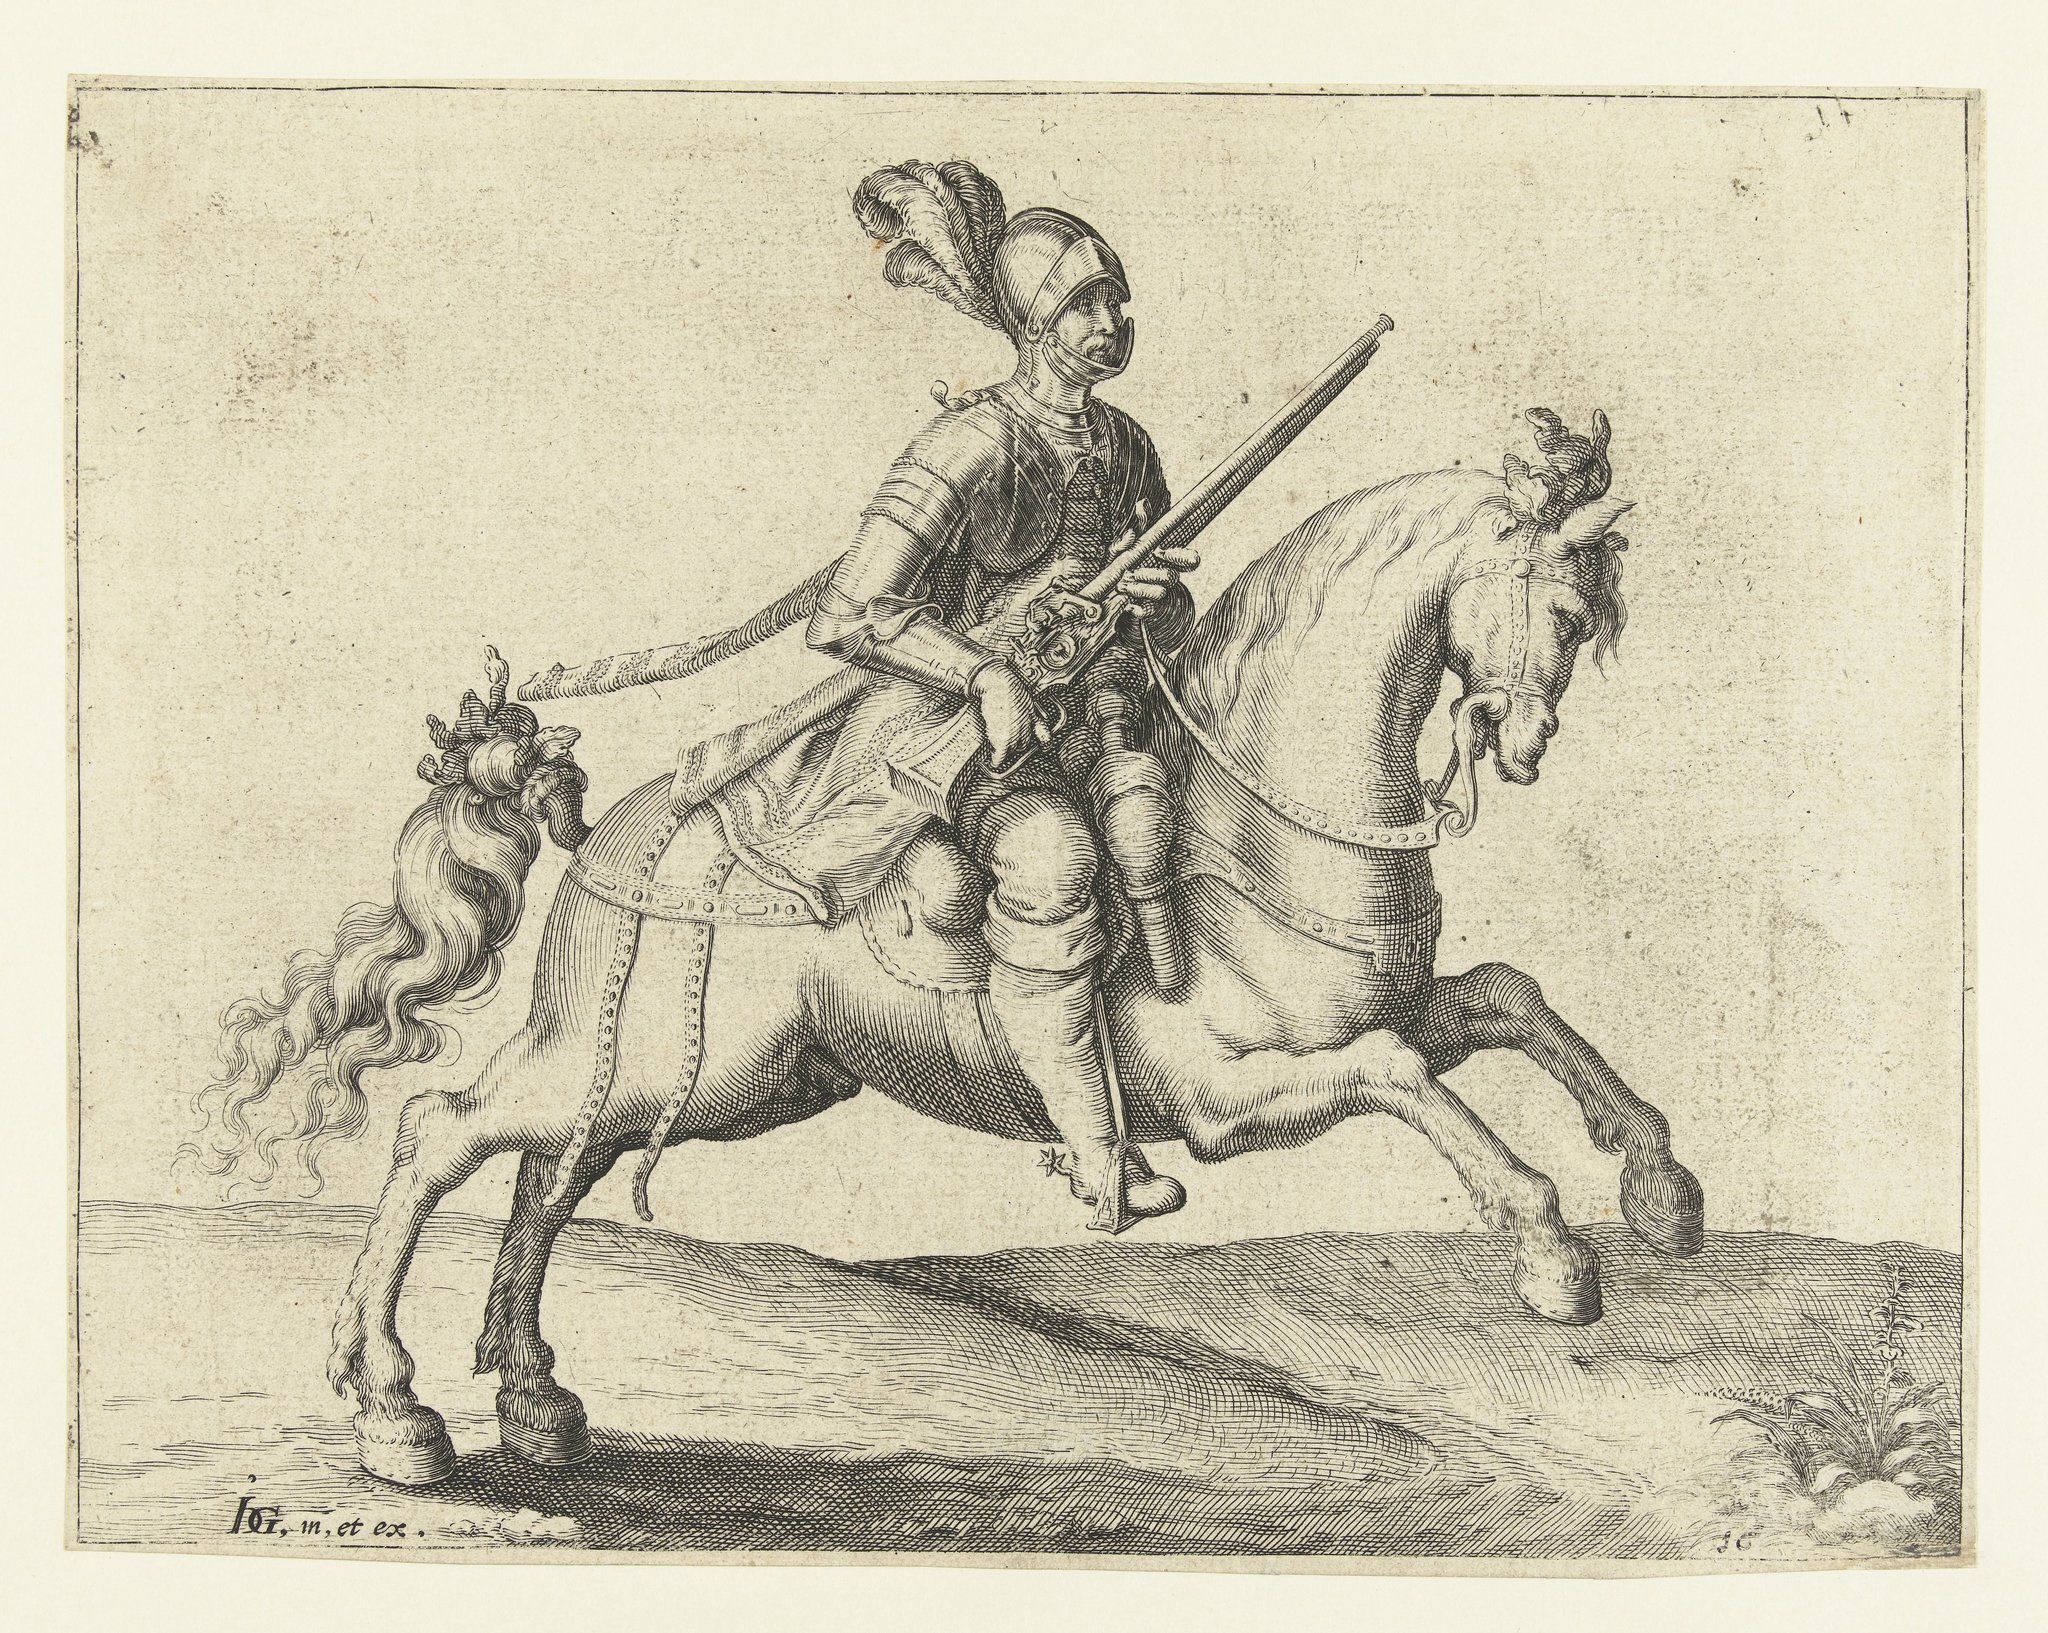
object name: print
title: Ruiter met harquebus, naar links gekeerd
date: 1599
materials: paper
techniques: engraving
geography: netherlands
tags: warfare; military affairs (+ cavalry, horsemen), firearms: rifle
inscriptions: collector's mark: Lugt 2228a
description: Een geharnaste man te paard, naar rechts rijdend, een harquebus (licht type geweer) in de handen. Deze prent is onderdeel van een serie van 22 genummerde prenten: een titelprent, 20 prenten waarop één of enkele verschillende typen (meest geharnaste) ruiters zijn weergegeven, en een prent met een ruitergevecht.